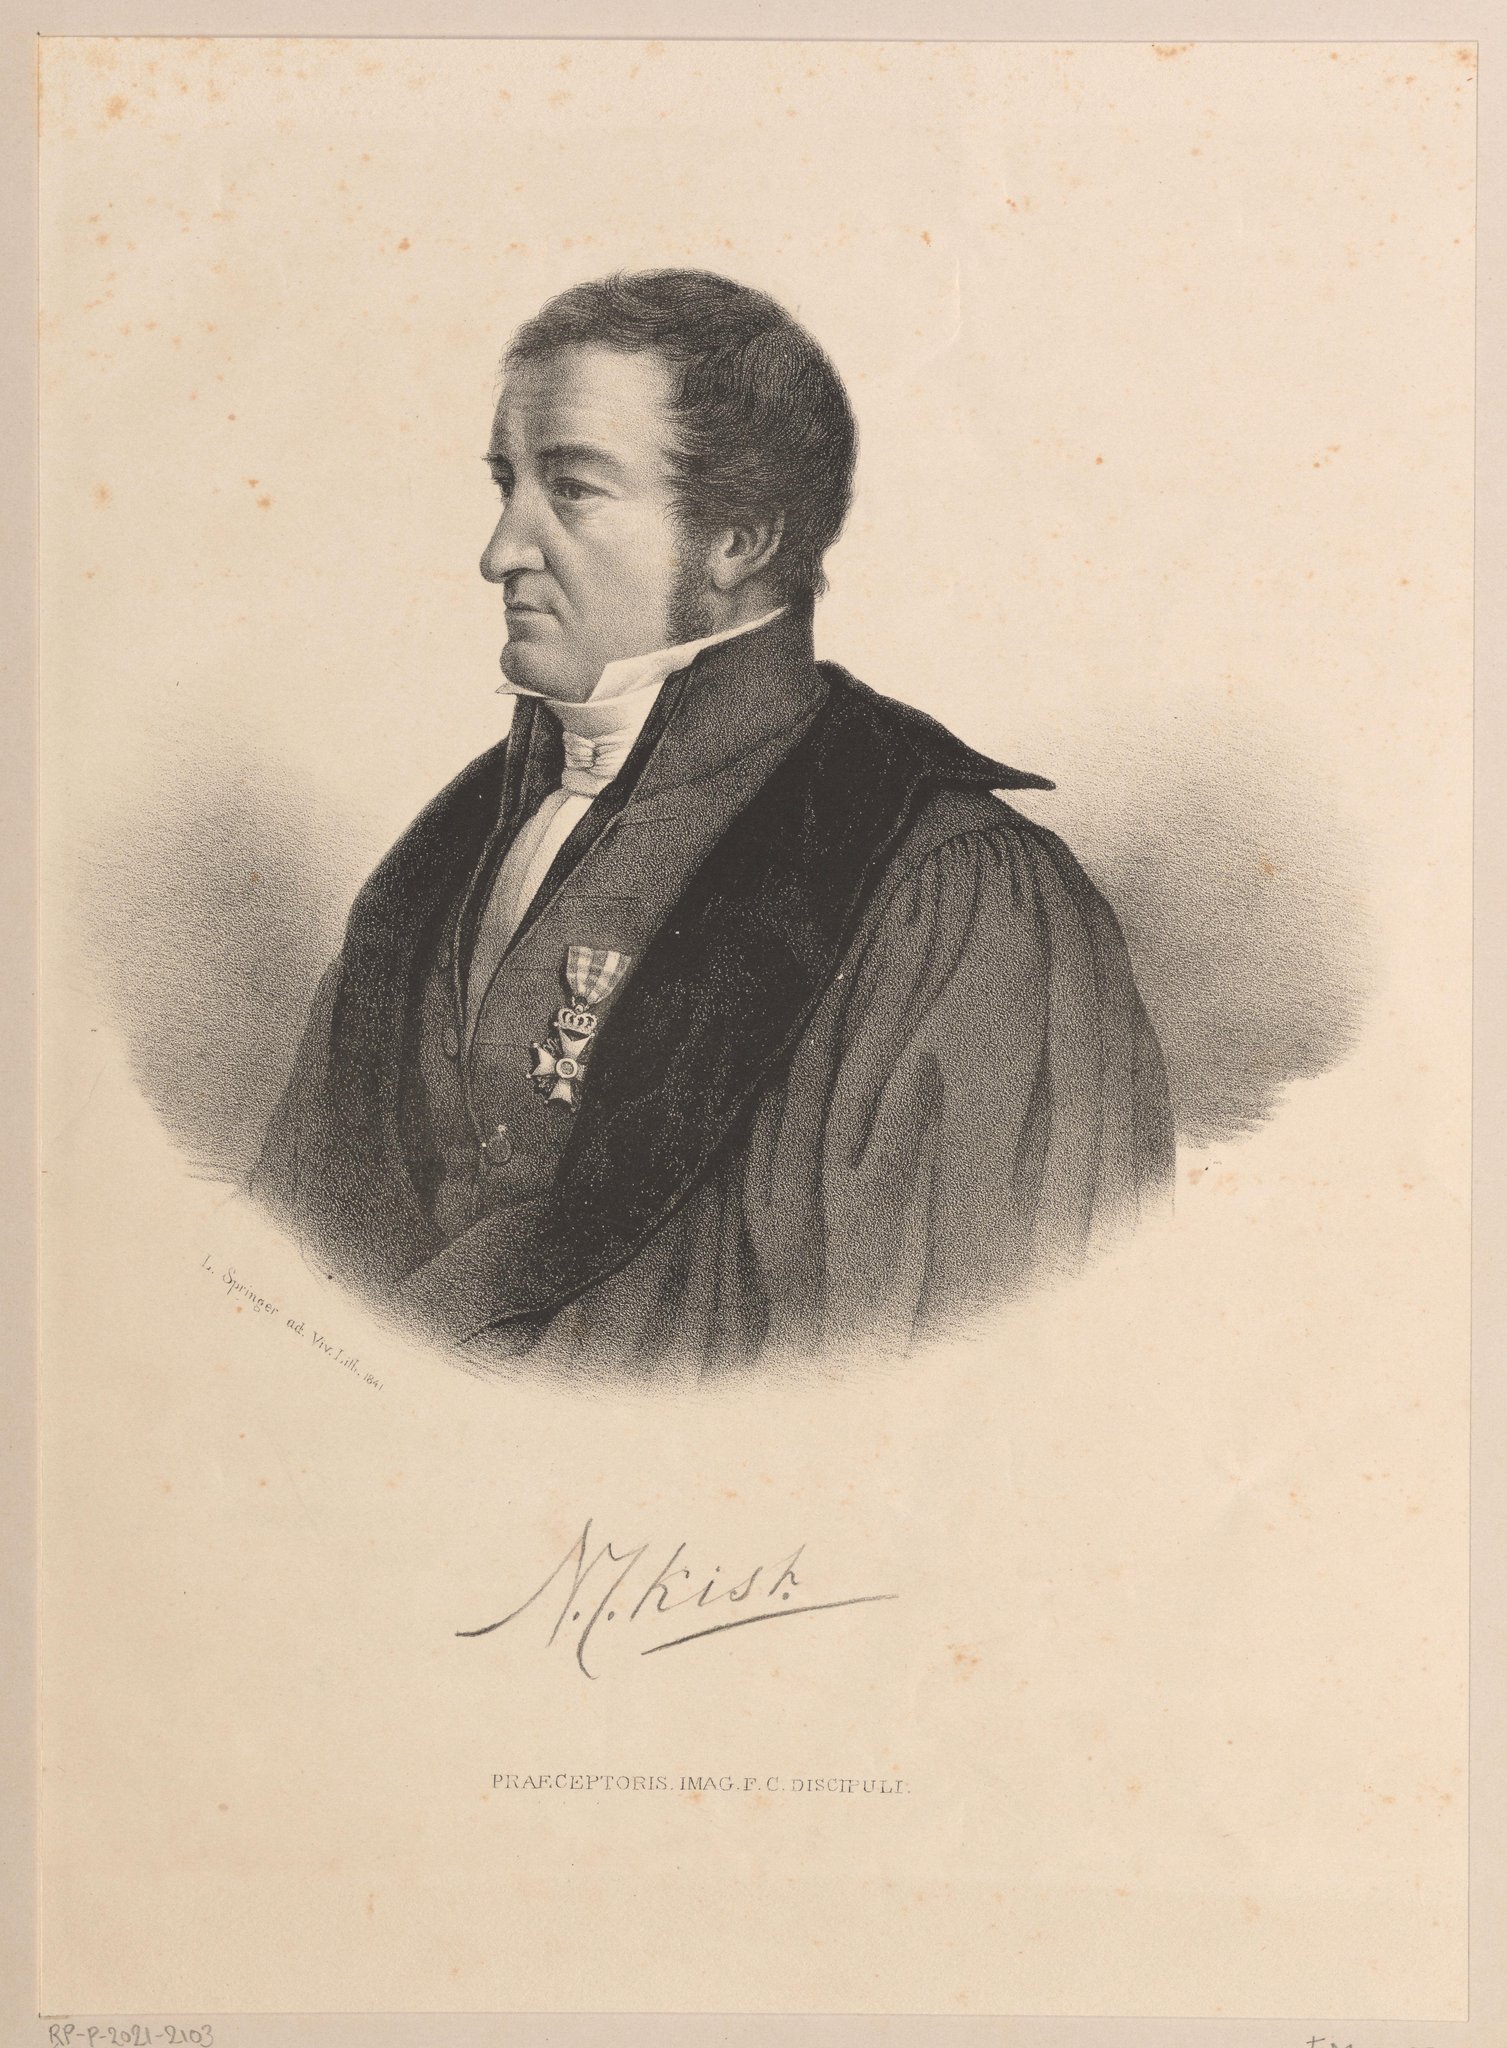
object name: print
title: Portret van Nicolaas Christiaan Kist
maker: leendert springer (i)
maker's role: draughtsman, painter, print maker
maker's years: 1789-1871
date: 1841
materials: paper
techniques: lithograph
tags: leiden, historical persons, medals and other marks of military honour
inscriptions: date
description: Onder het portret een facsimile van de handtekening van de geportretteerde.